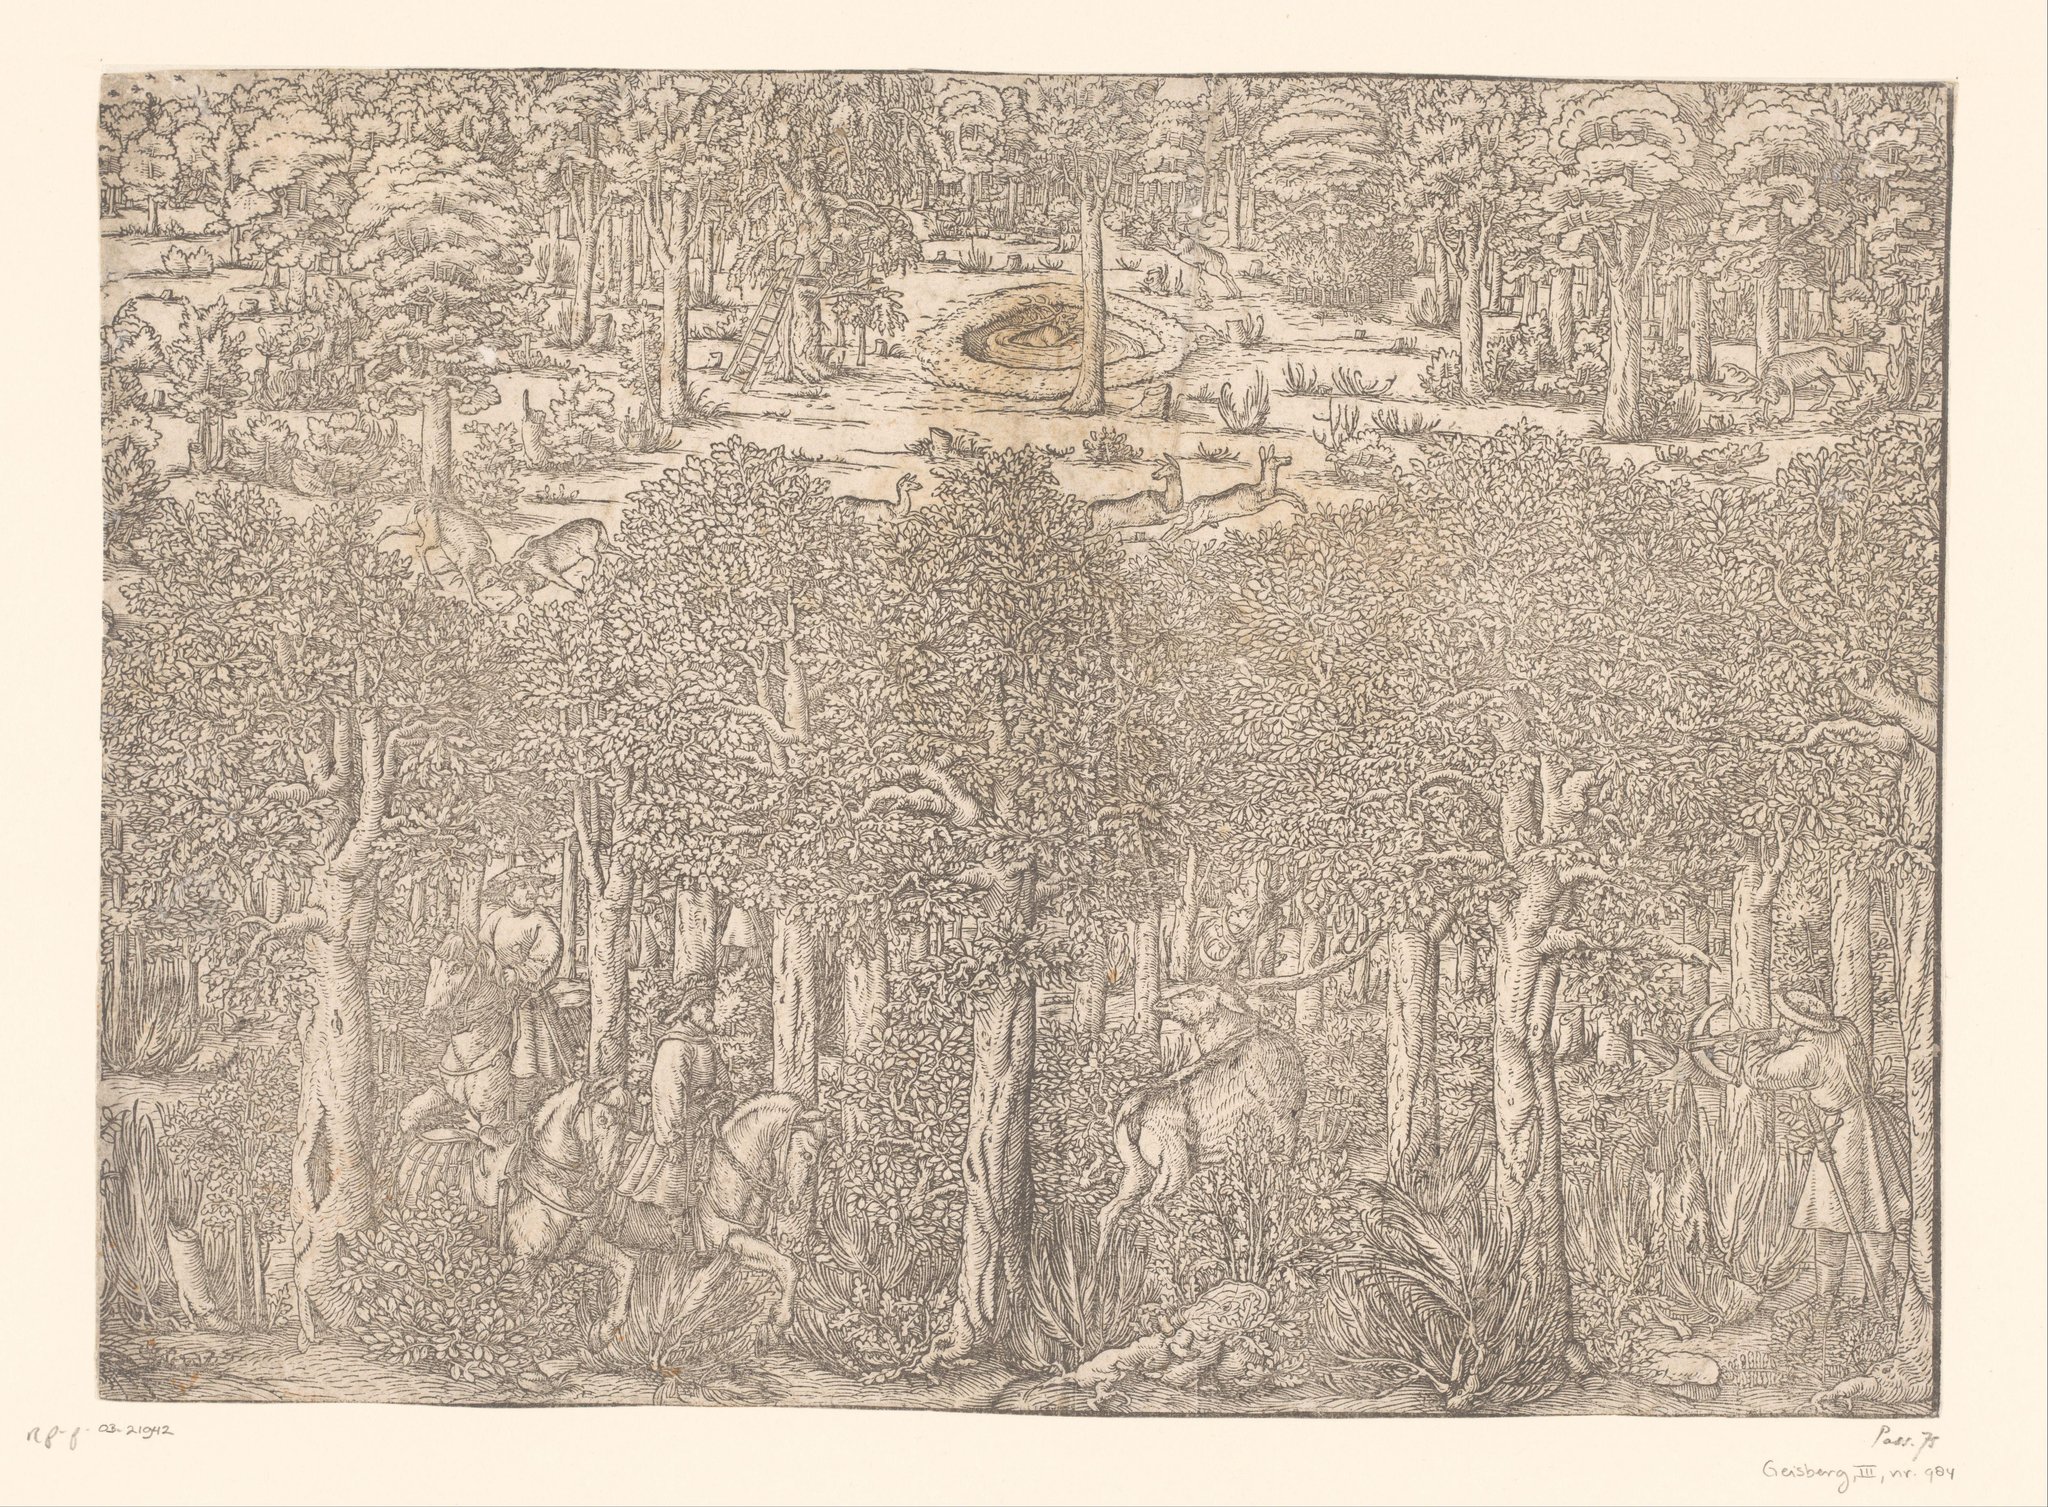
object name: print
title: Jachtpartij in het woud van Lörs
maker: Anonymous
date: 1543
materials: paper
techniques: woodcut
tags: stag-hunting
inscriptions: collector's mark: Lugt 280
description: Rechterblok van een serie van drie prenten met een jachtpartij in het woud van Lörs als onderwerp.